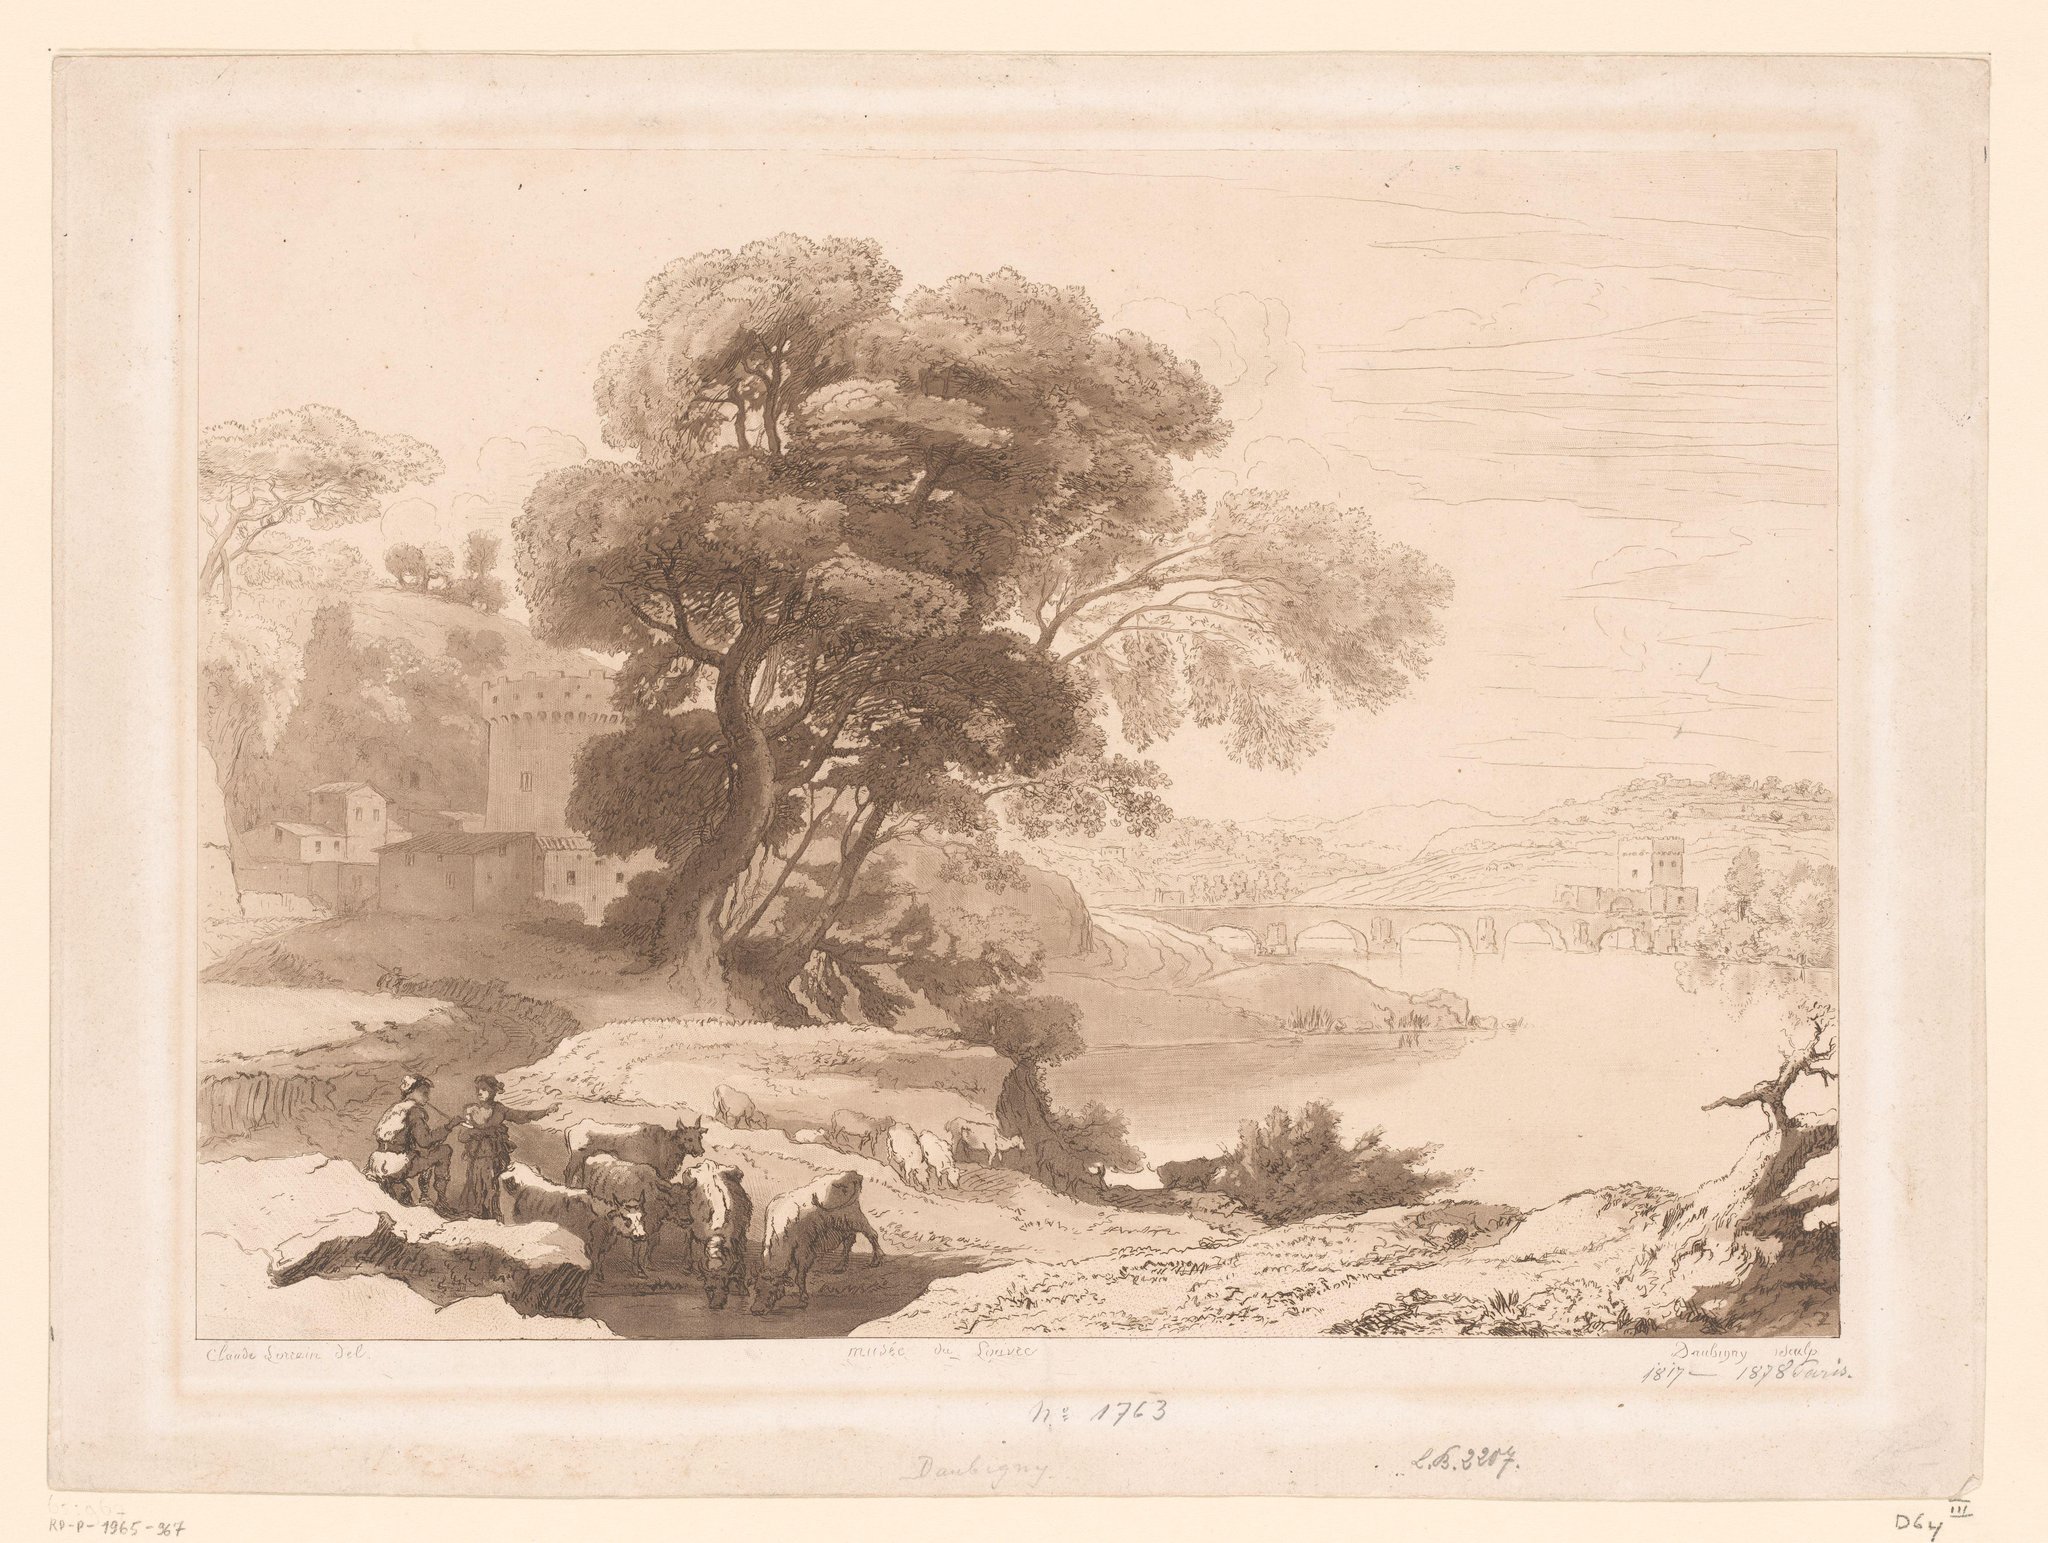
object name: print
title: Landschap met herders en vee aan de rand van een rivier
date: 1849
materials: paper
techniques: etching, roulette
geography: france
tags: landscapes, herding, herdsman, herdswoman, shepherd, shepherdess, cowherd, etc., landscape with bridge, viaduct or aqueduct, herd, flock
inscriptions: collector's mark: Lugt 2228